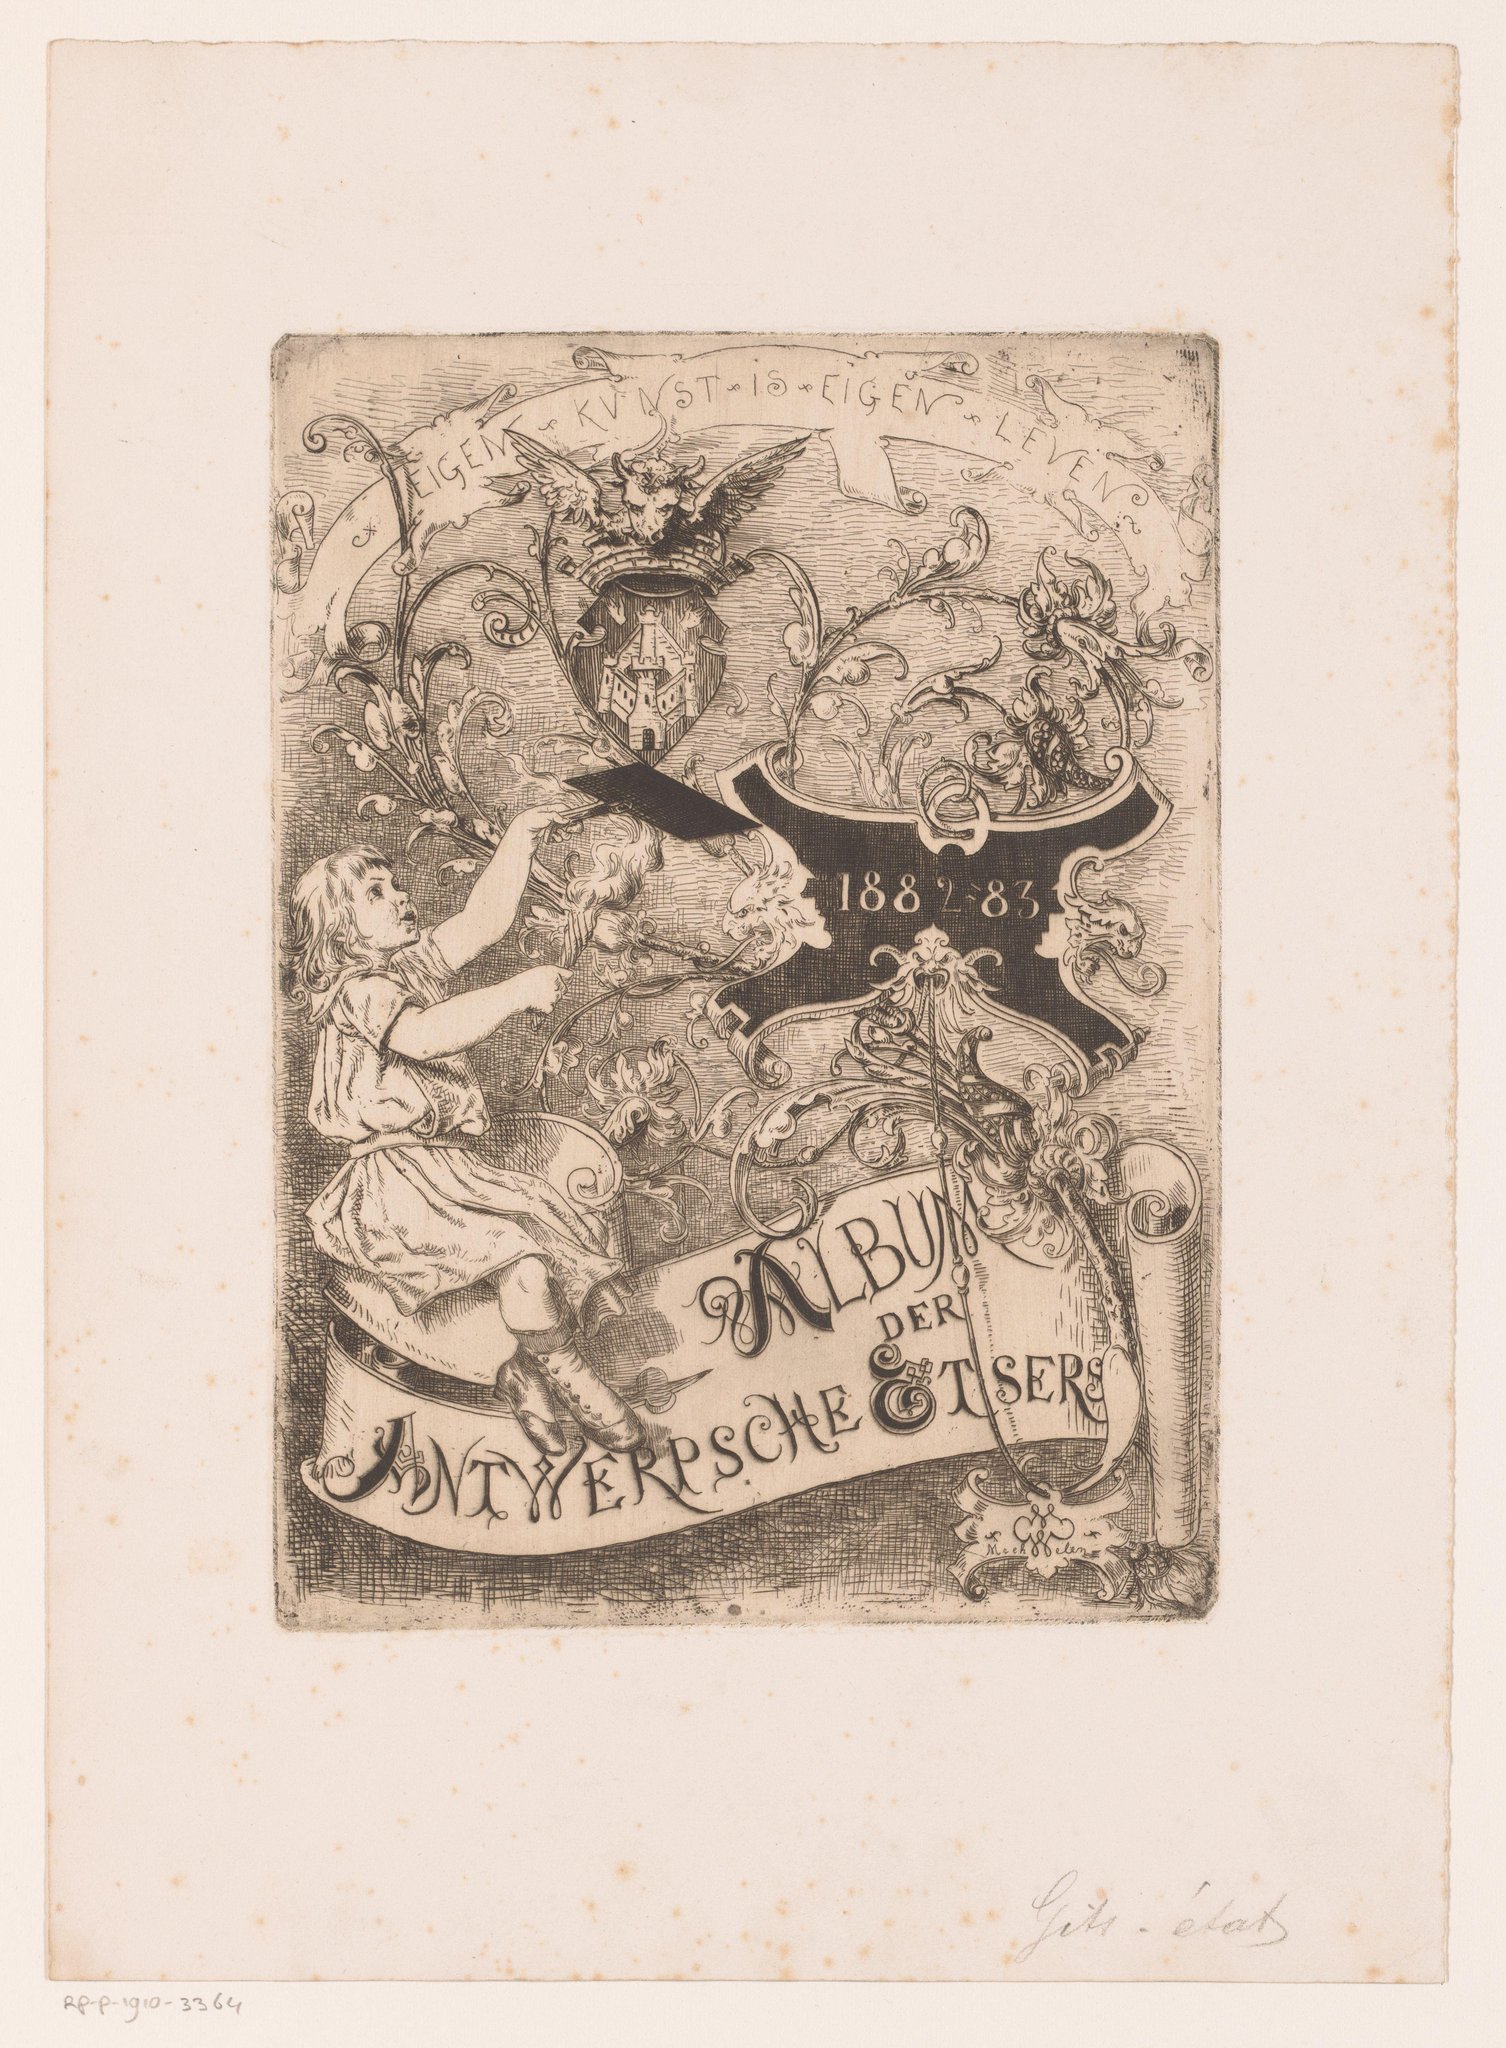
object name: titelprent, frontispice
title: Album der Antwerpsche Etsers 1882-1883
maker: willem geets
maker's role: print maker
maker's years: 1838-1919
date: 1882-1883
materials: paper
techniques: etching, intaglio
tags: coat of arms (as symbol of the state, etc.), child, ornament ~ cartouche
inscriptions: collector's mark: Lugt 2228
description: Waarschijnlijk titelprent voor: Album der Antwerpsche Etsers. S.l.: Vereeniging der Antwerpsche Etsers, 1882-1883.